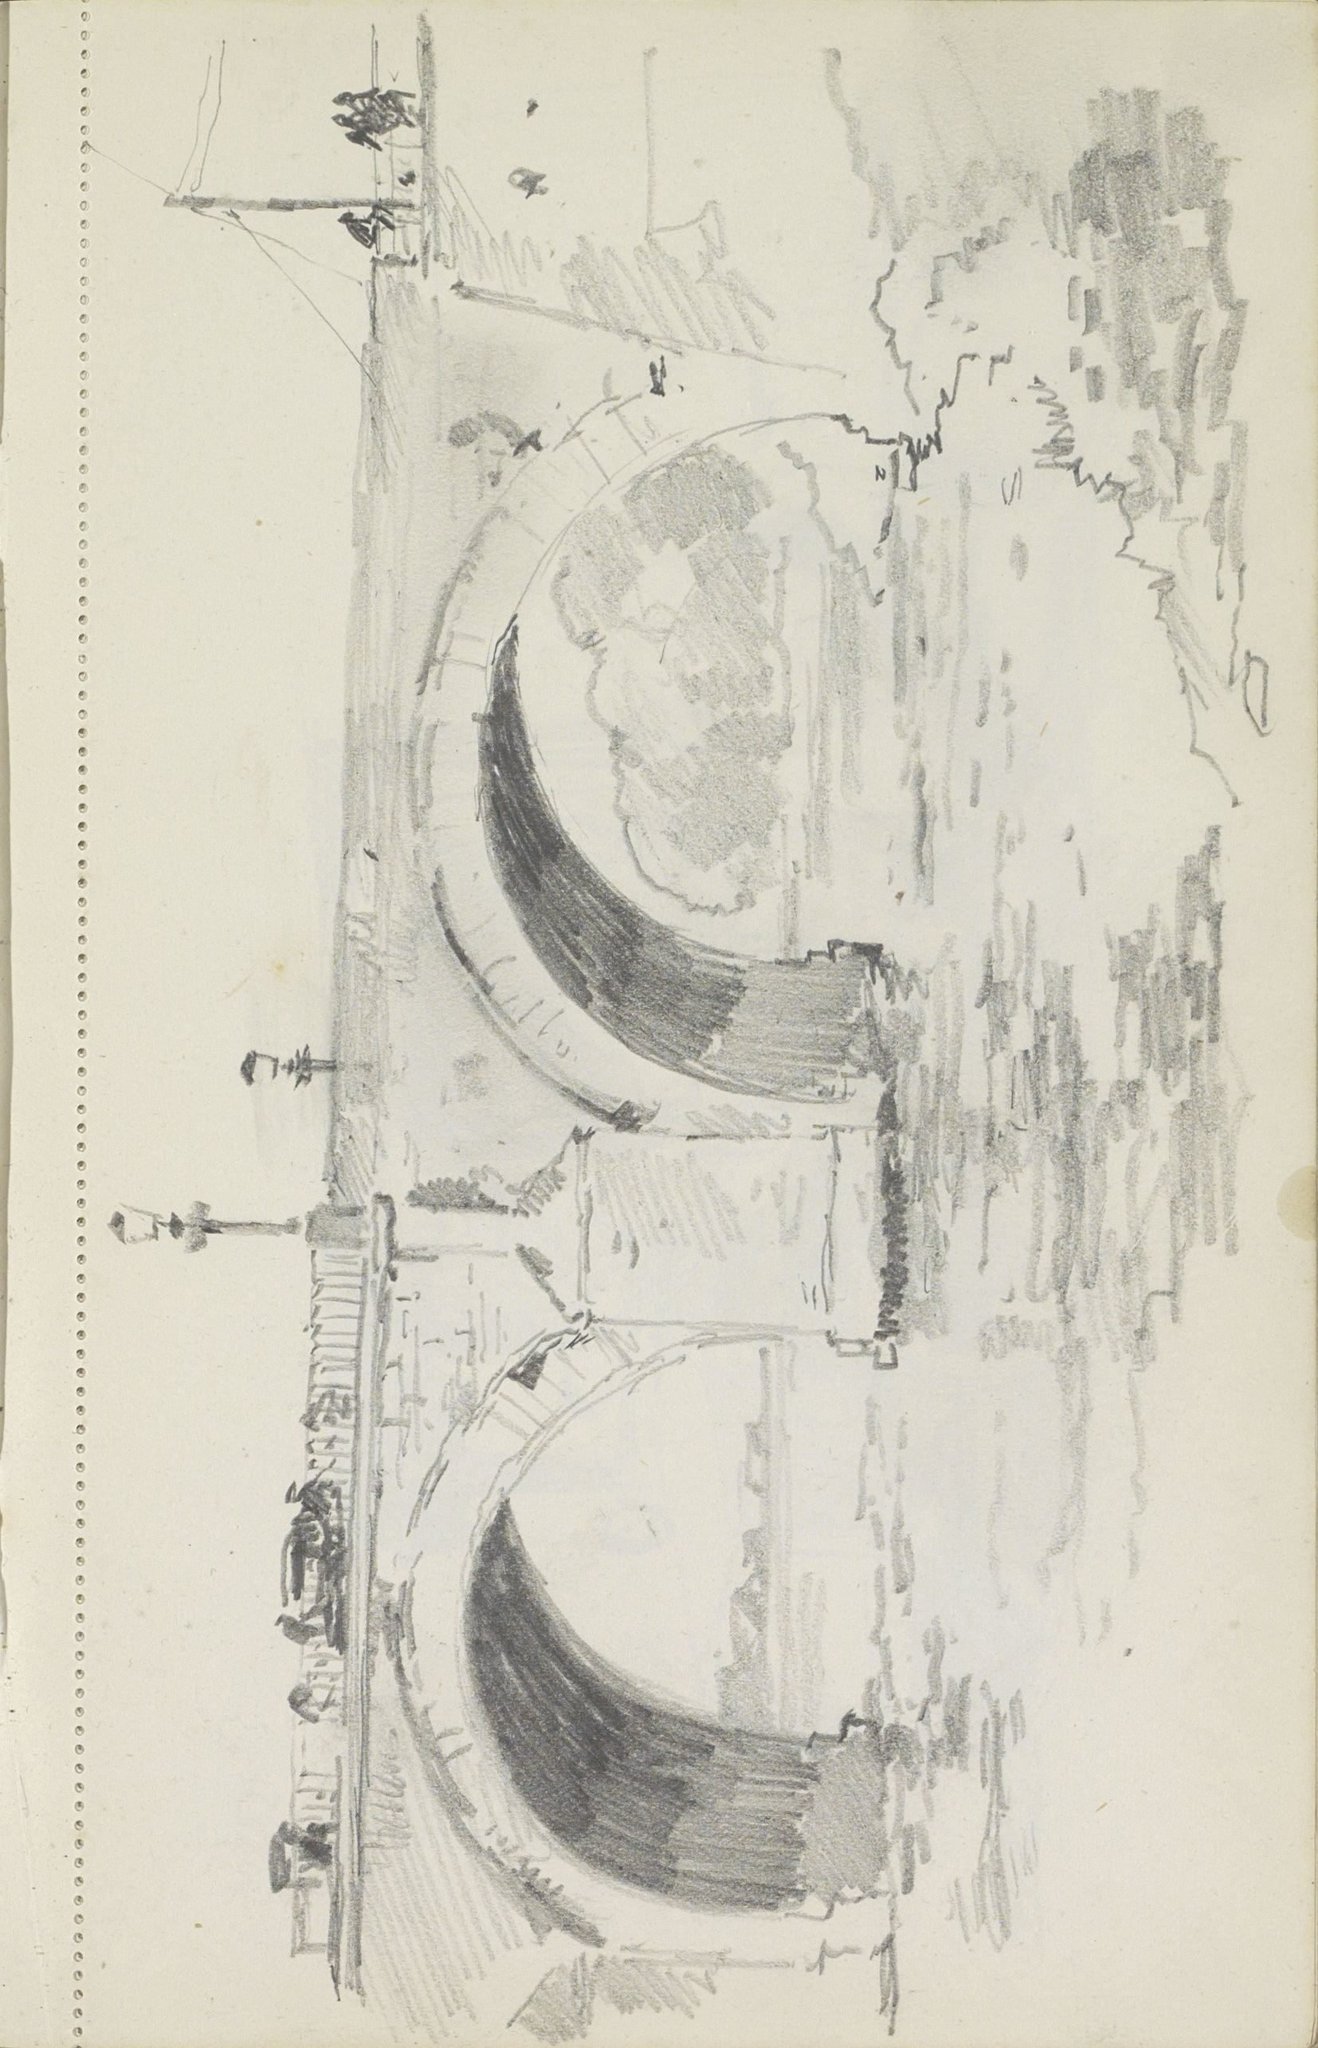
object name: sketchbook leaf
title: Brug met twee bogen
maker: cornelis vreedenburgh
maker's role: draughtsman, print maker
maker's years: 1880-1946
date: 1890-1946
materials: paper, pencil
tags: bridge in city across river, canal, etc.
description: Blad 7 recto uit een schetsboek met 50 bladen.